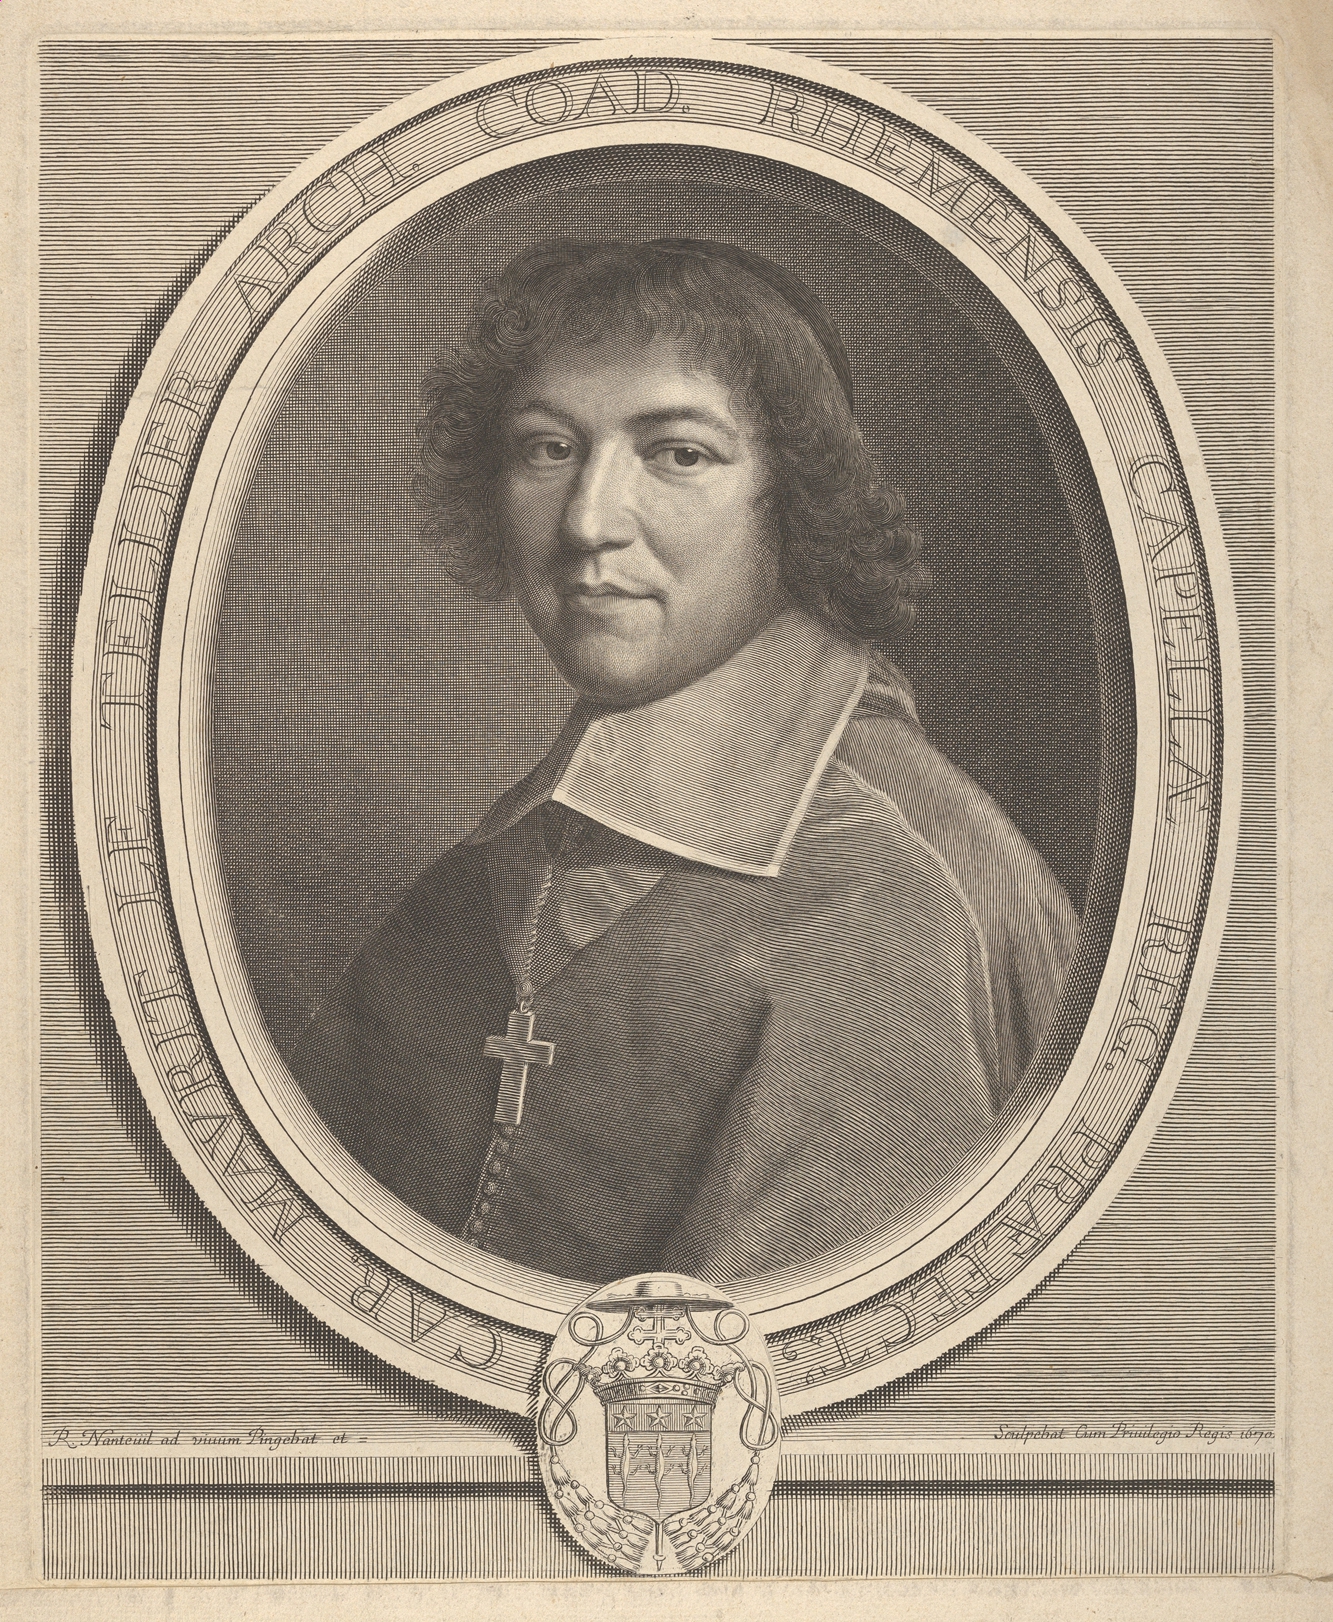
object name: print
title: Charles-Maurice Le Tellier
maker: robert nanteuil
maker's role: artist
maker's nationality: french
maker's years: 1623-1678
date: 1670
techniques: engraving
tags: men,portraits